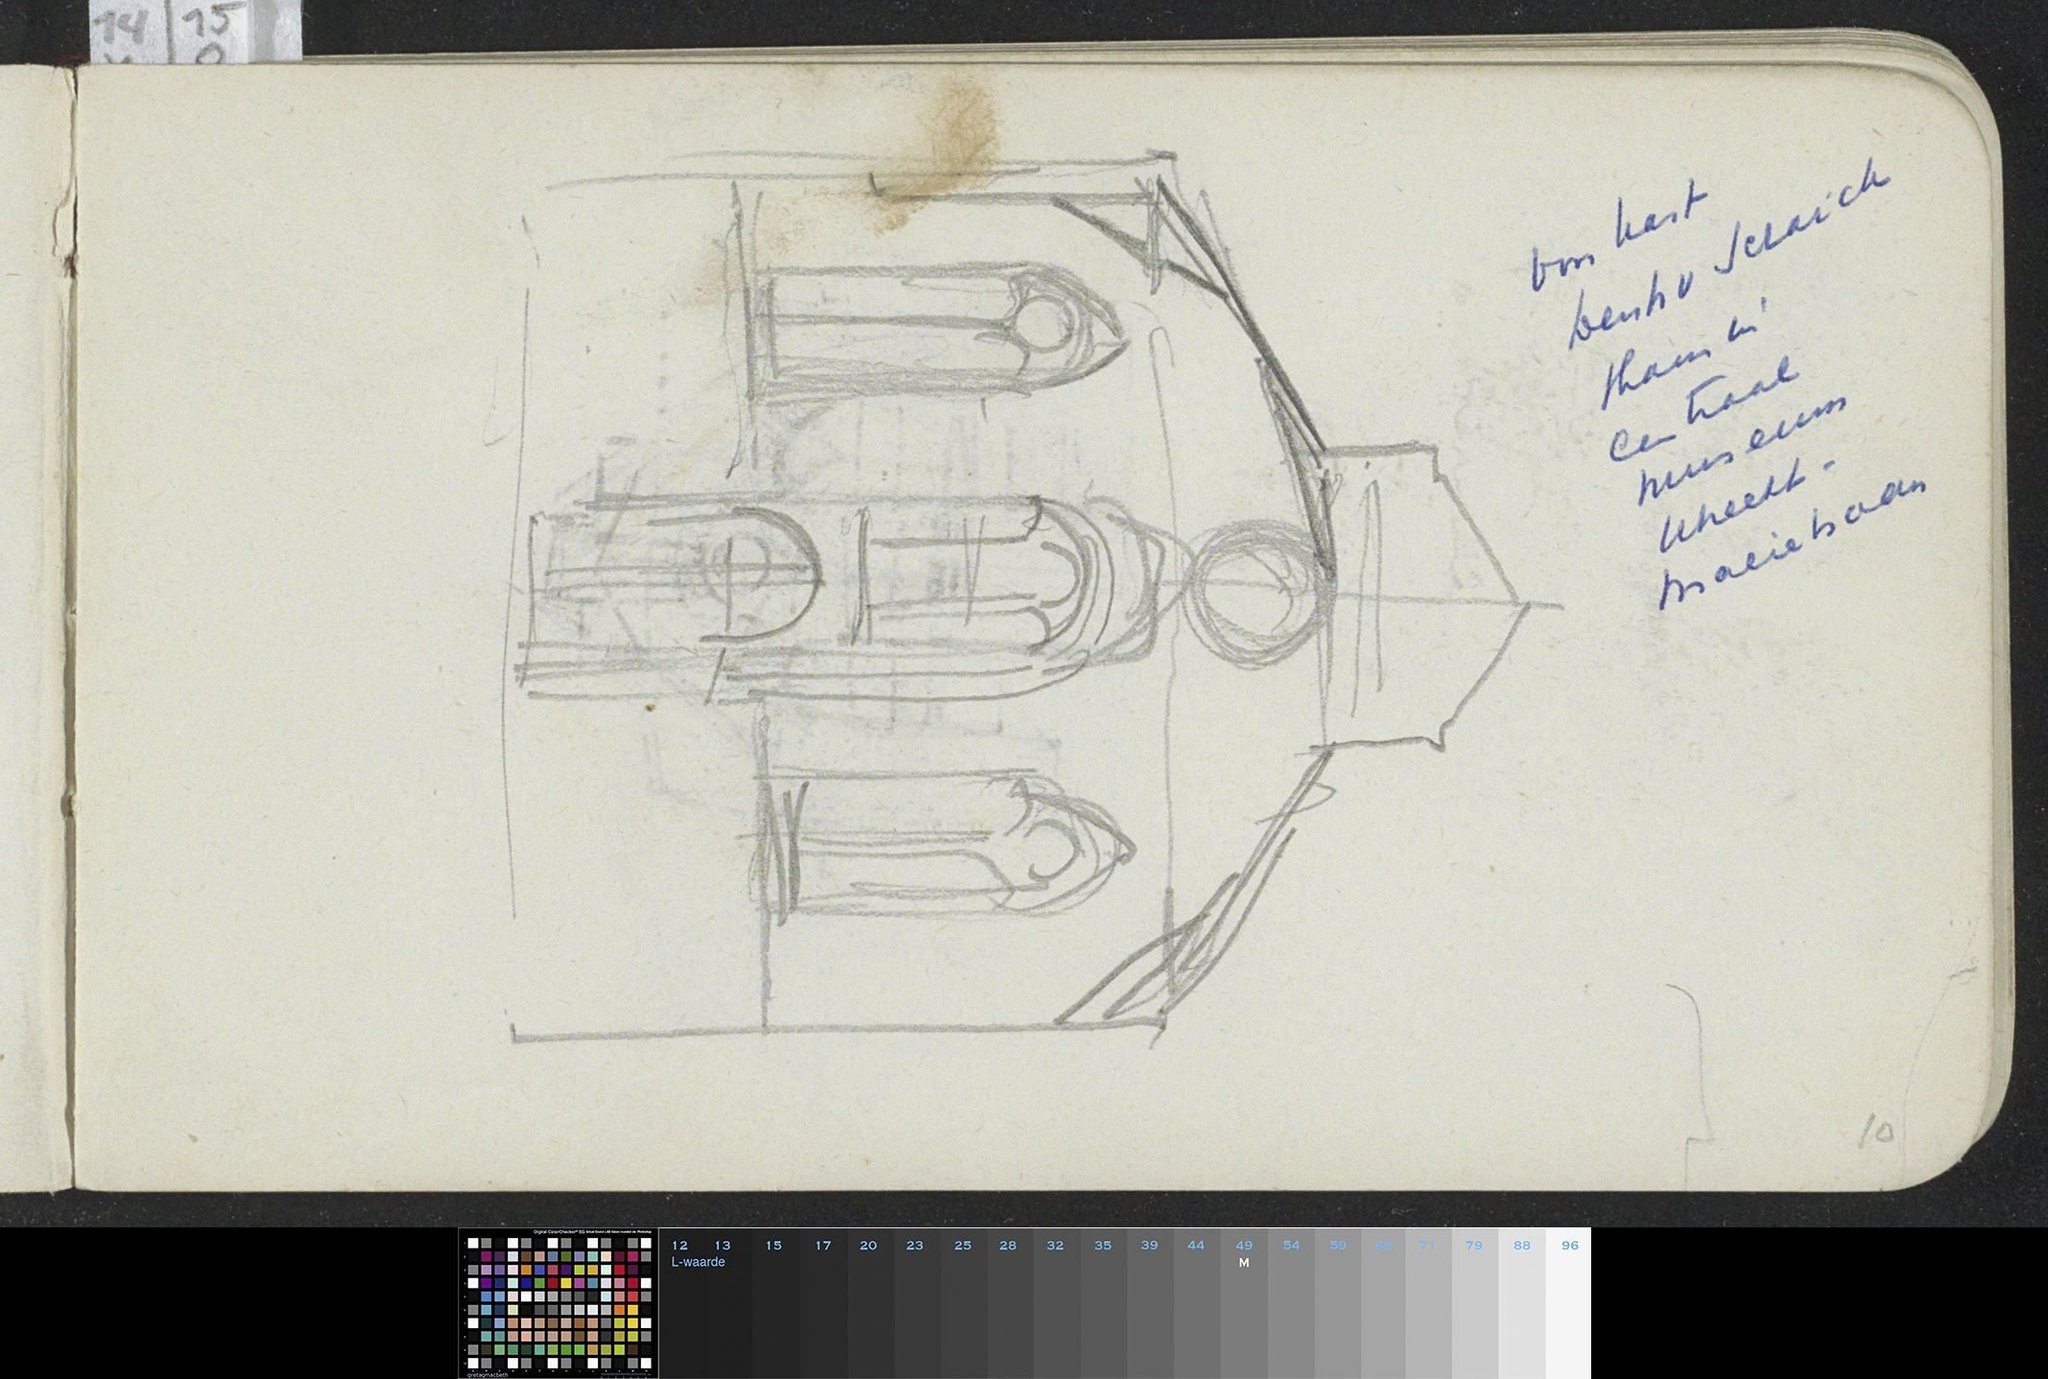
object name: sketchbook leaf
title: Vooraanzicht van een kerk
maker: carel adolph lion cachet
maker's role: draughtsman, print maker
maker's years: 1864-1945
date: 1905-1906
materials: paper, pencil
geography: vreeland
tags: church (exterior)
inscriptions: annotation: ‘van kast/ Dentz v Schaick/ thans in/ Centraal Museum/ Utrecht-/ maliebaan’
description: Blad 10 recto uit een schetsboek met 34 bladen.